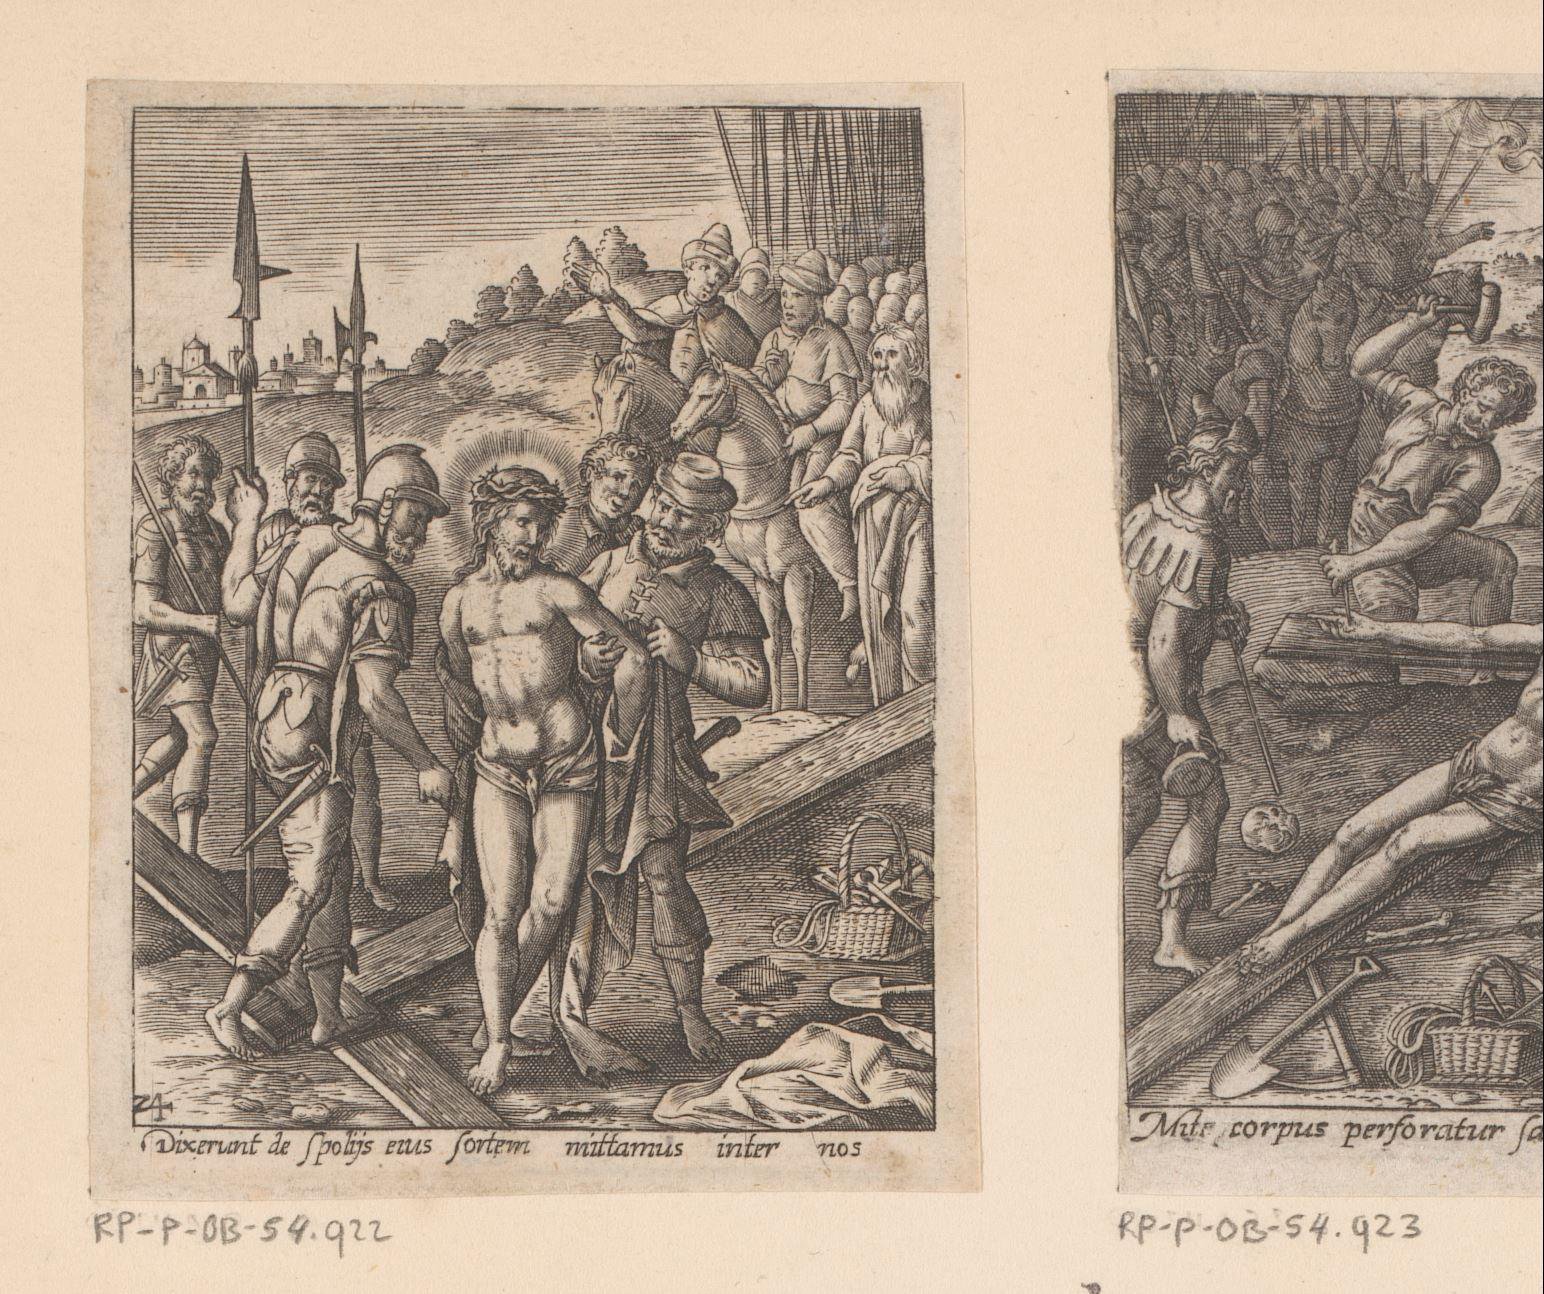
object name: print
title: Leven, passie en wederopstanding van Christus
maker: heinrich ulrich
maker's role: draughtsman, painter, print maker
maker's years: 1572-1671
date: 1582-1671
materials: paper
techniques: engraving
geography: germany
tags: christ disrobed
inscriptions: number: ‘38. - 64.’, collector's mark: Lugt 240